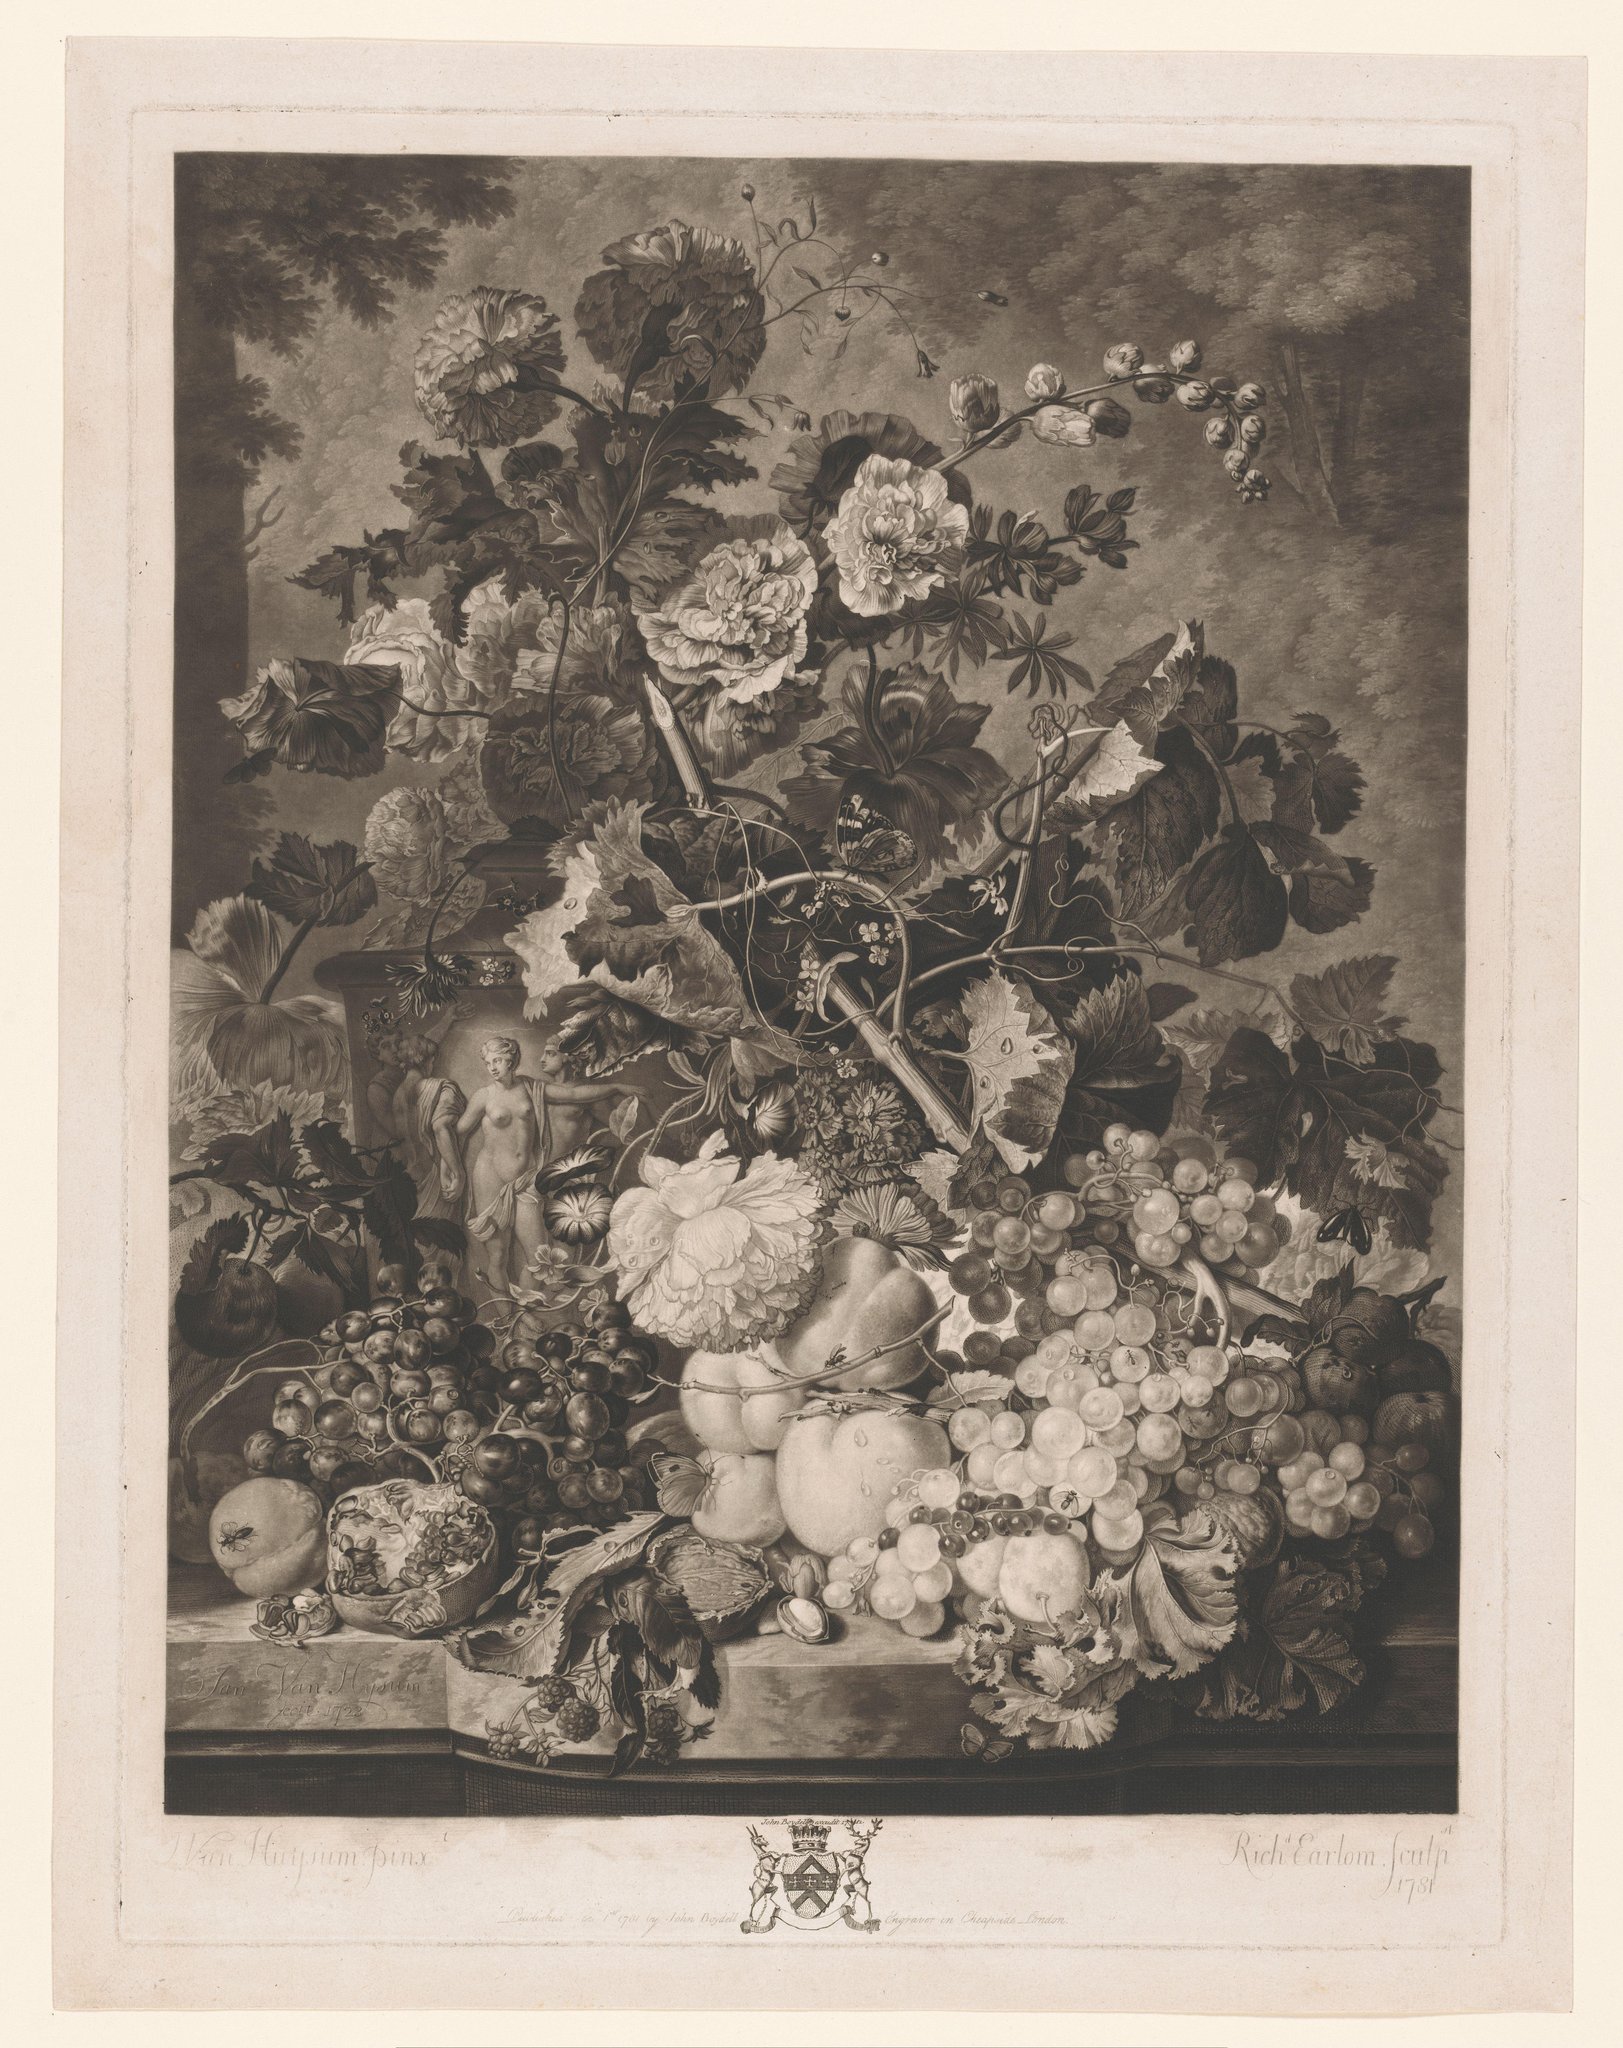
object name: print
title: Still Life of Fruit and Flowers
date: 1723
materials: paper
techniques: etching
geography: london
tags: still life of plants, flowers and fruit, container of stone: stone vase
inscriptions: collector's mark: Lugt 2228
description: Right before Empress Catherine the Great of Russia bought Sir Robert Walpole’s entire art collection, Richard Earlom made large prints of several of the famous paintings in it as mementos. Among them was this 1723 still life by Jan van Huysum. Earlom worked in mezzotint, a technique also called the ‘black manner’. This method made it possible to produce soft, subtle transitions between a wealth of grey tones, creating a velvety black surface.